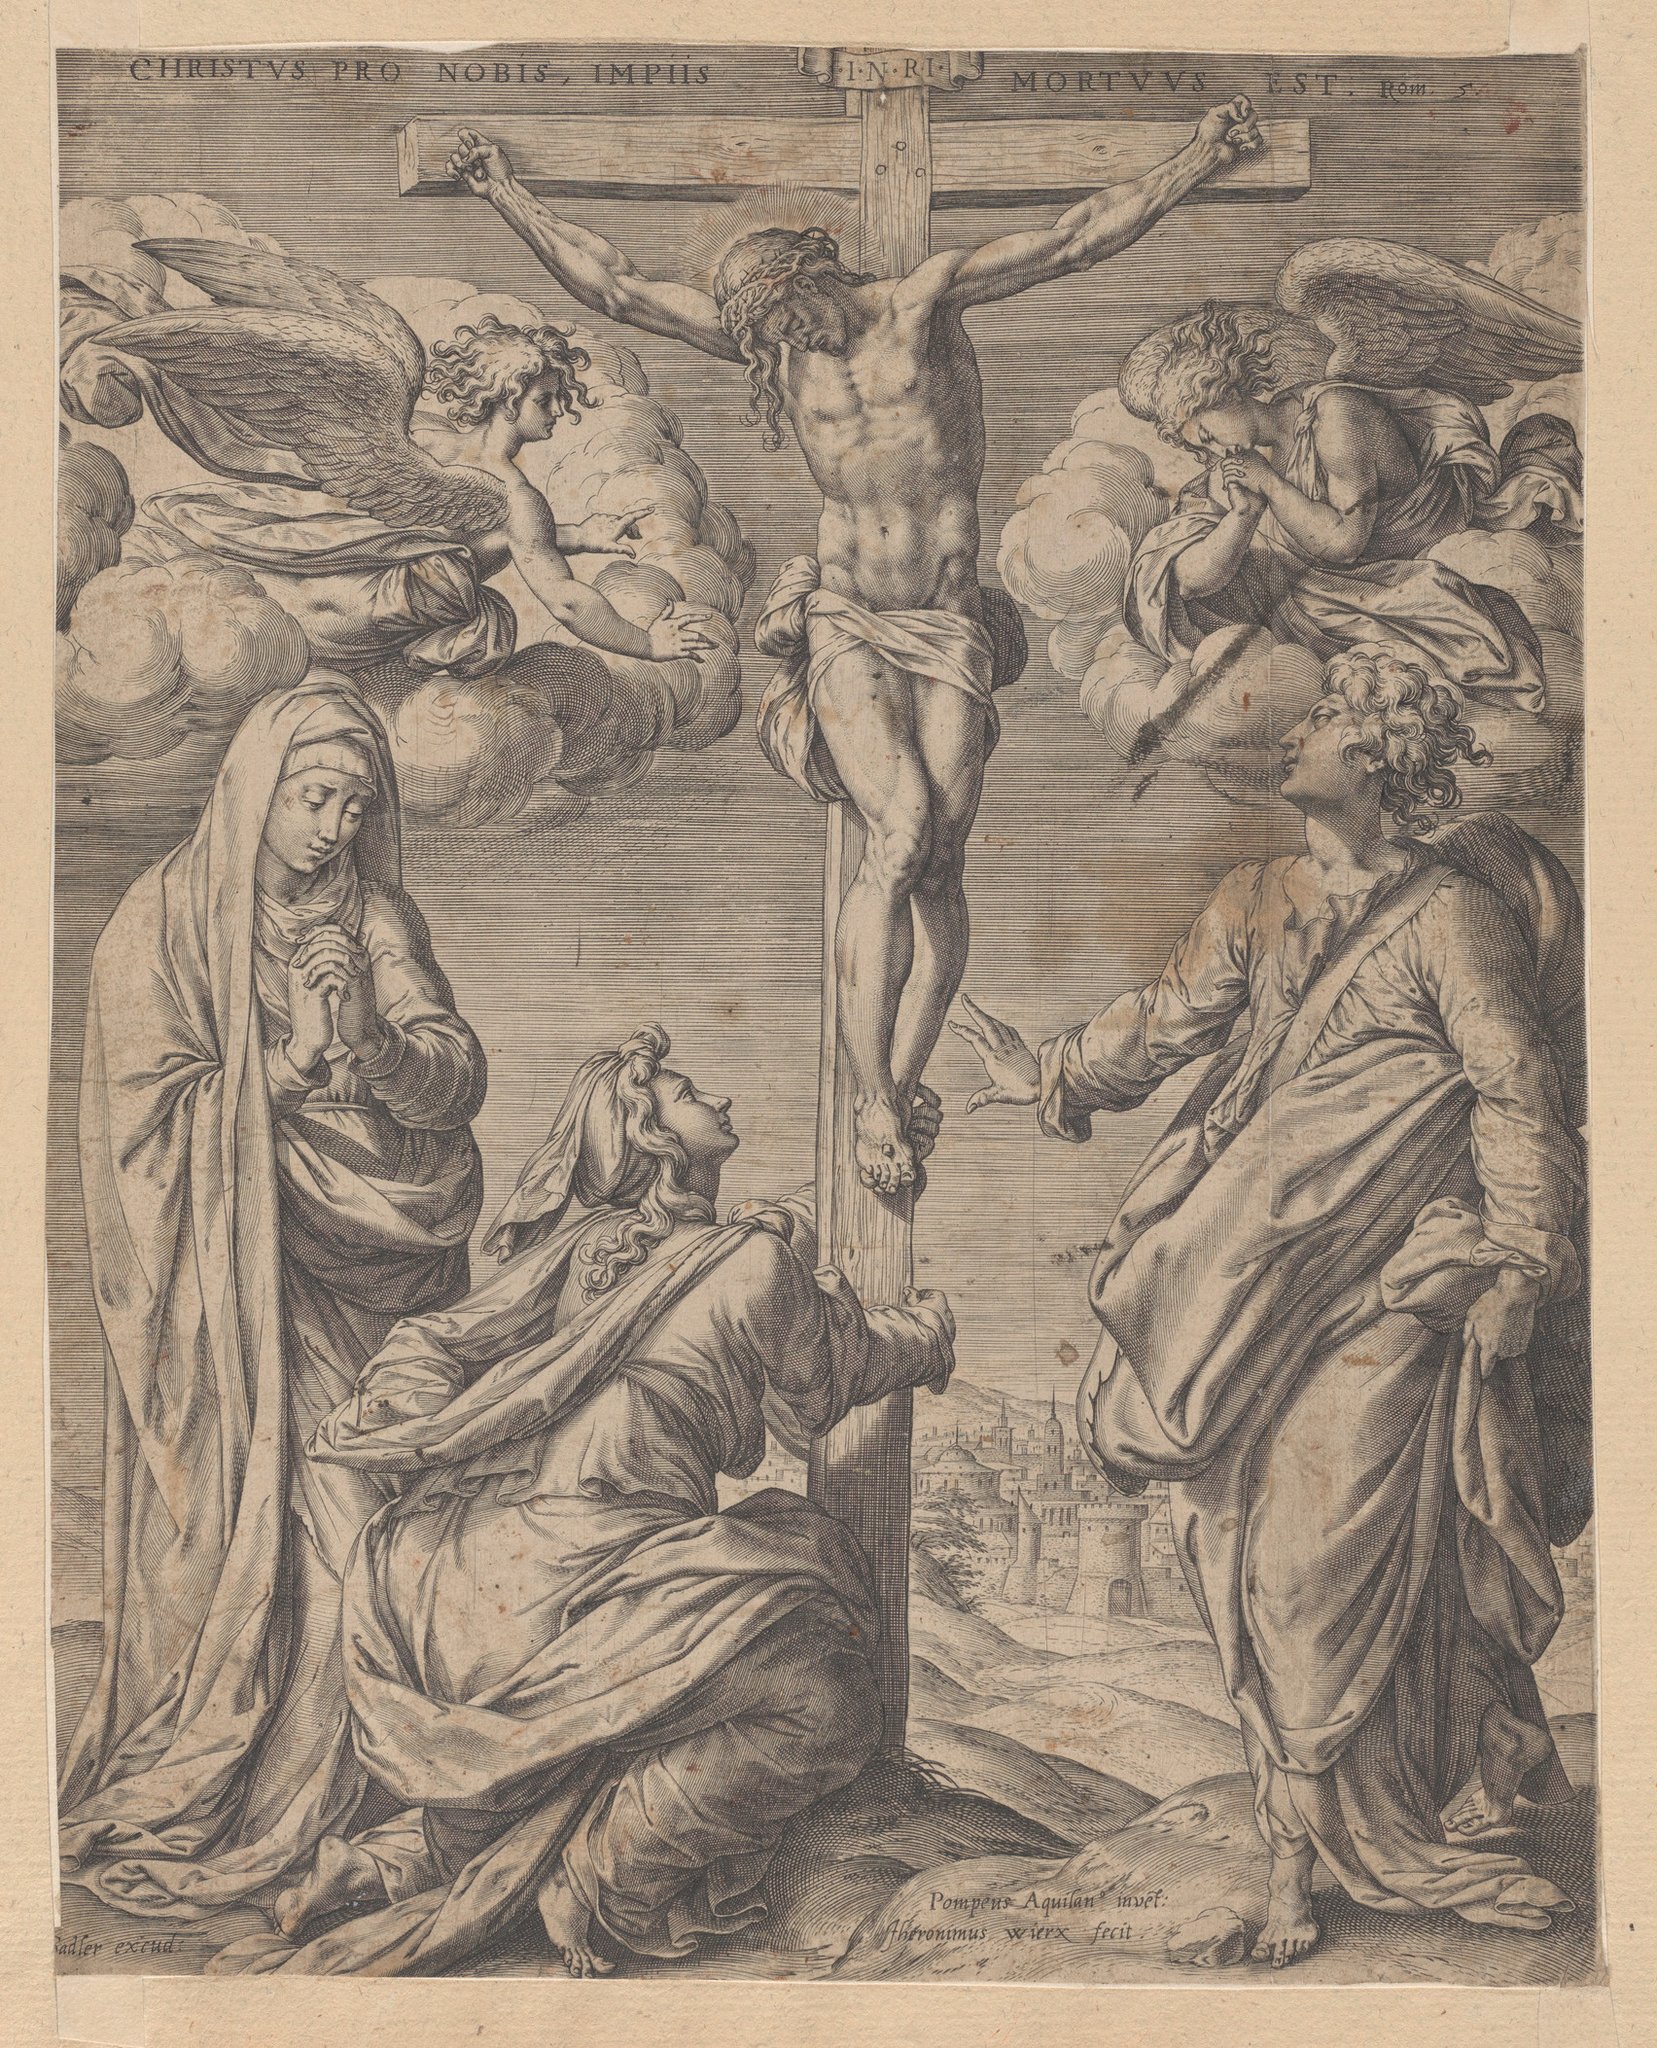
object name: print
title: The Lamentation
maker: hieronymus wierix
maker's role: artist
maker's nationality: netherlandish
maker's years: 1553-1619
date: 1598-1632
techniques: engraving